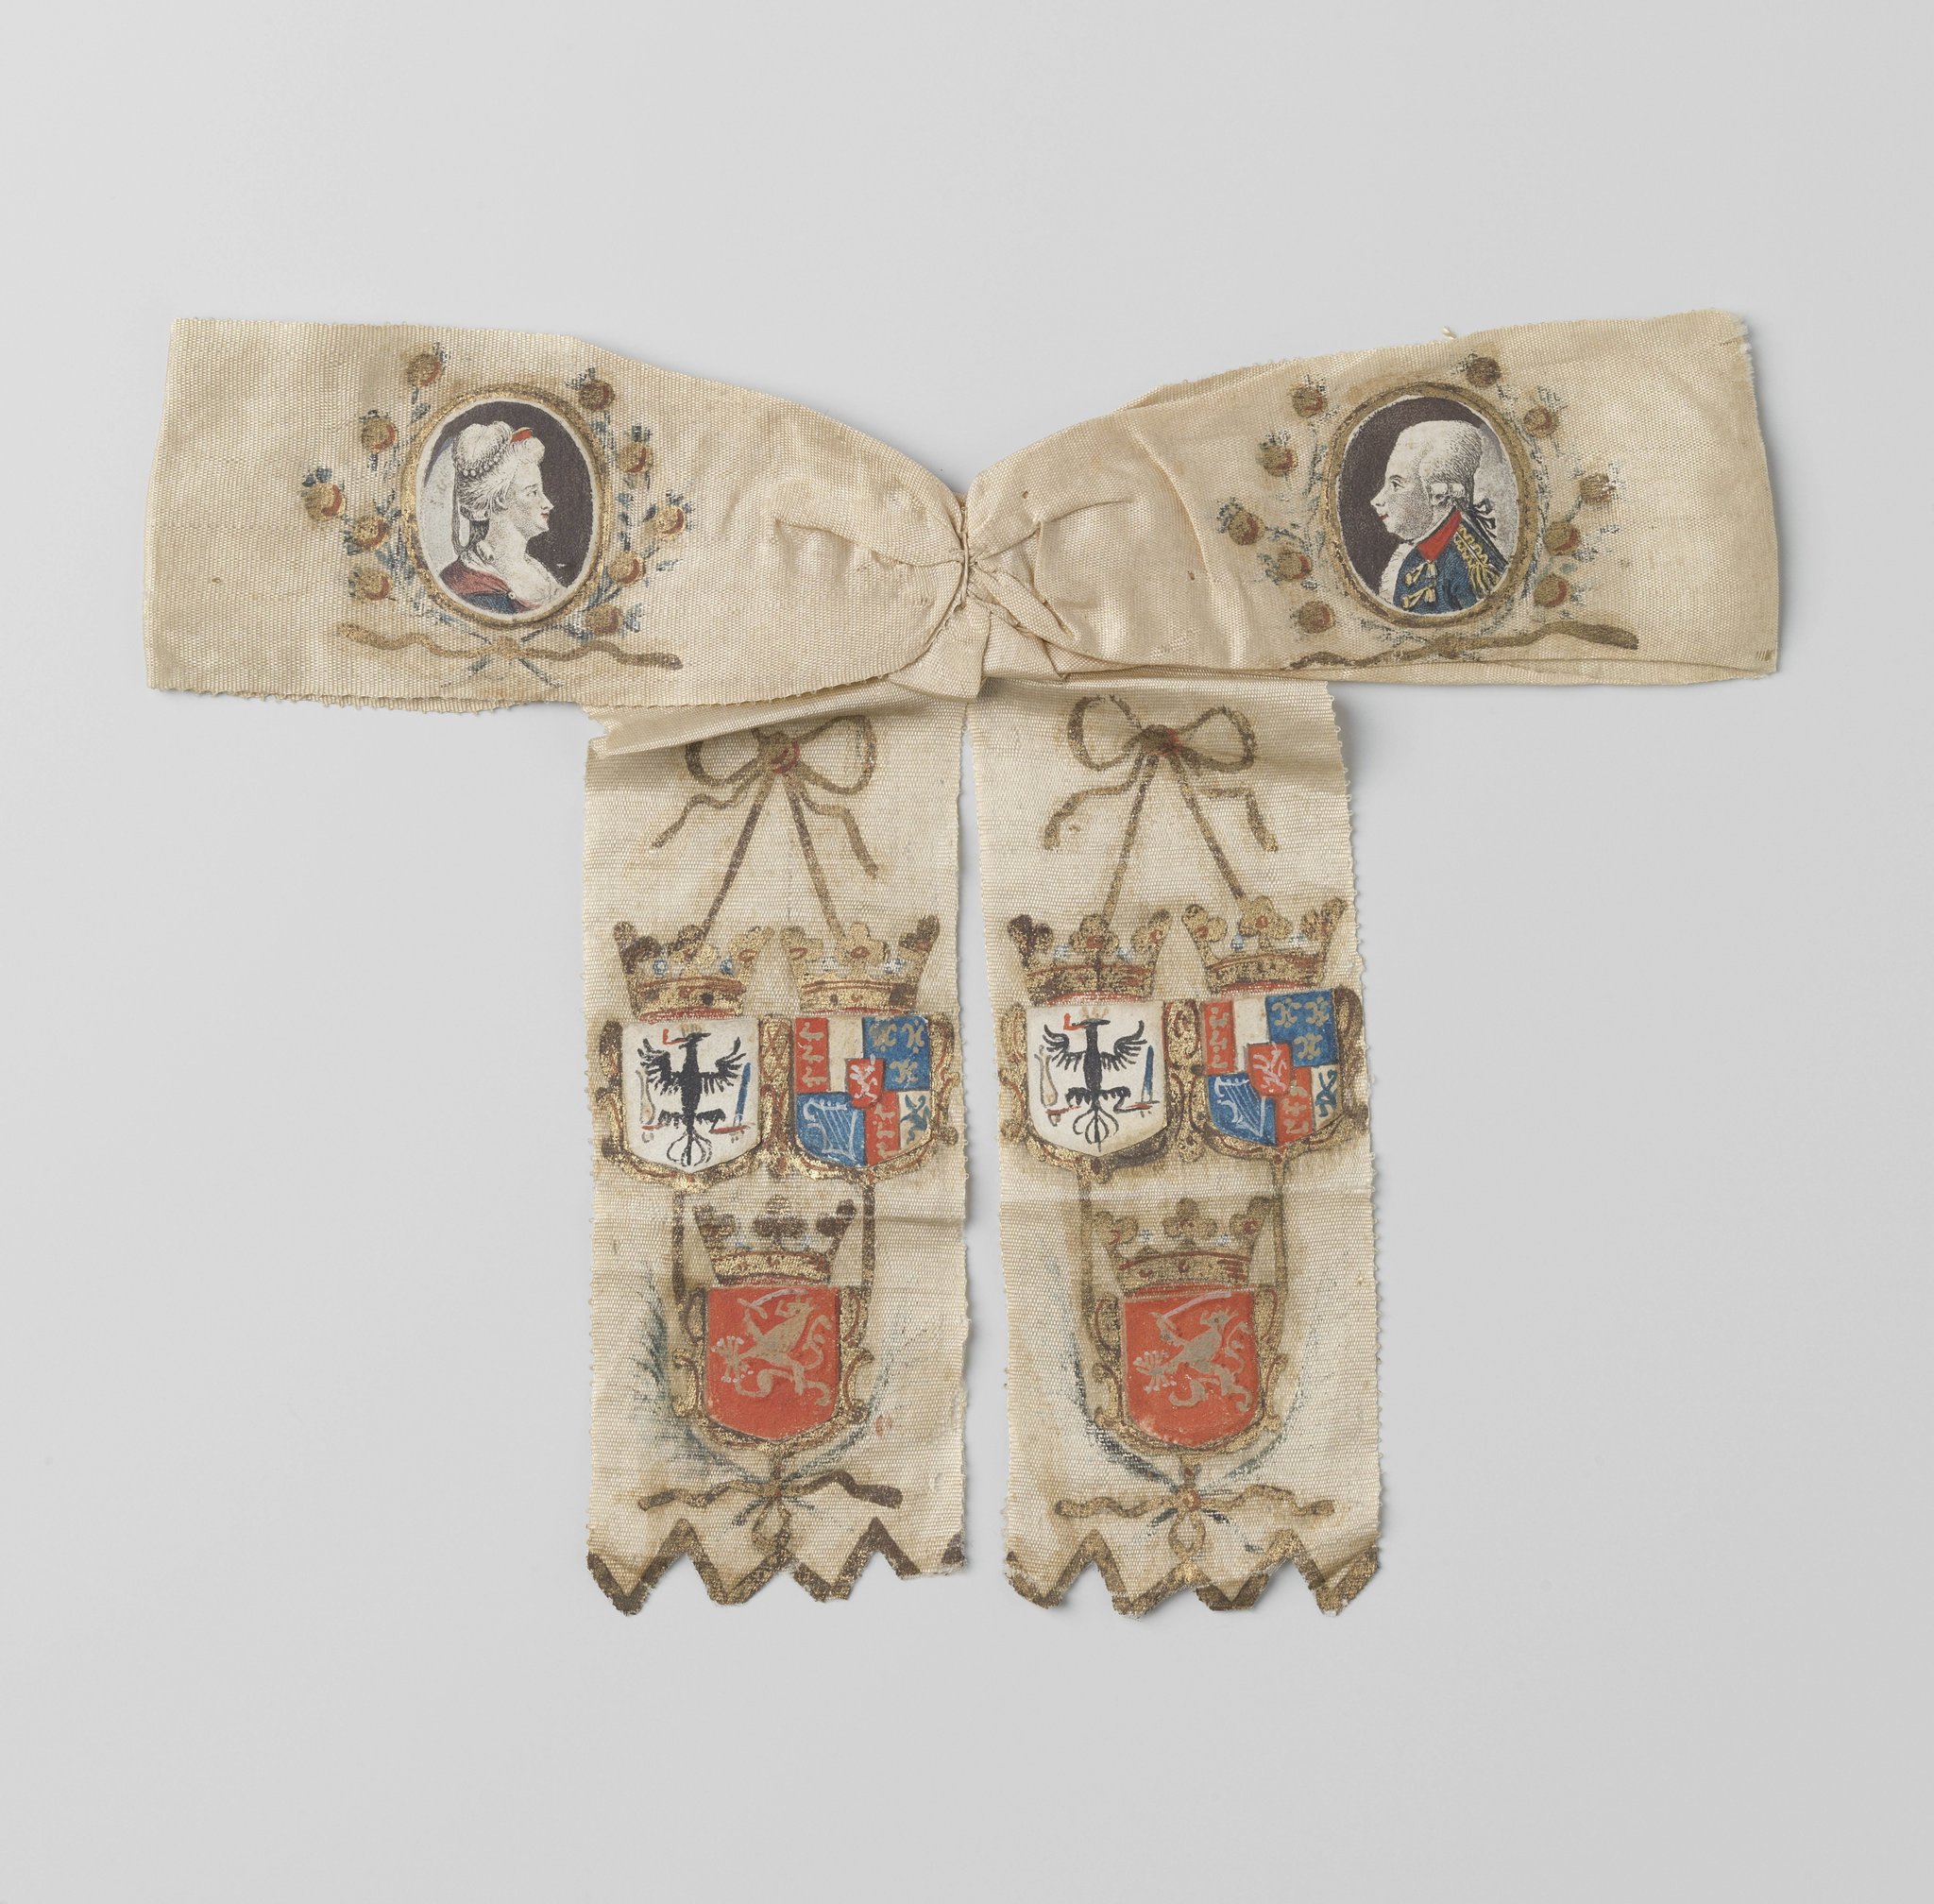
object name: ribbon material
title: Oranjelint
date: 1787-1788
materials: paper, silk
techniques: printing, weave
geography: netherlands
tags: the hague, william v (prince of orange), berlin, painter, draughtsman, wilhelmina of prussia (princess of orange)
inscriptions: number: ‘3646X’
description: Orange ribbon with inscriptions and illustrations.